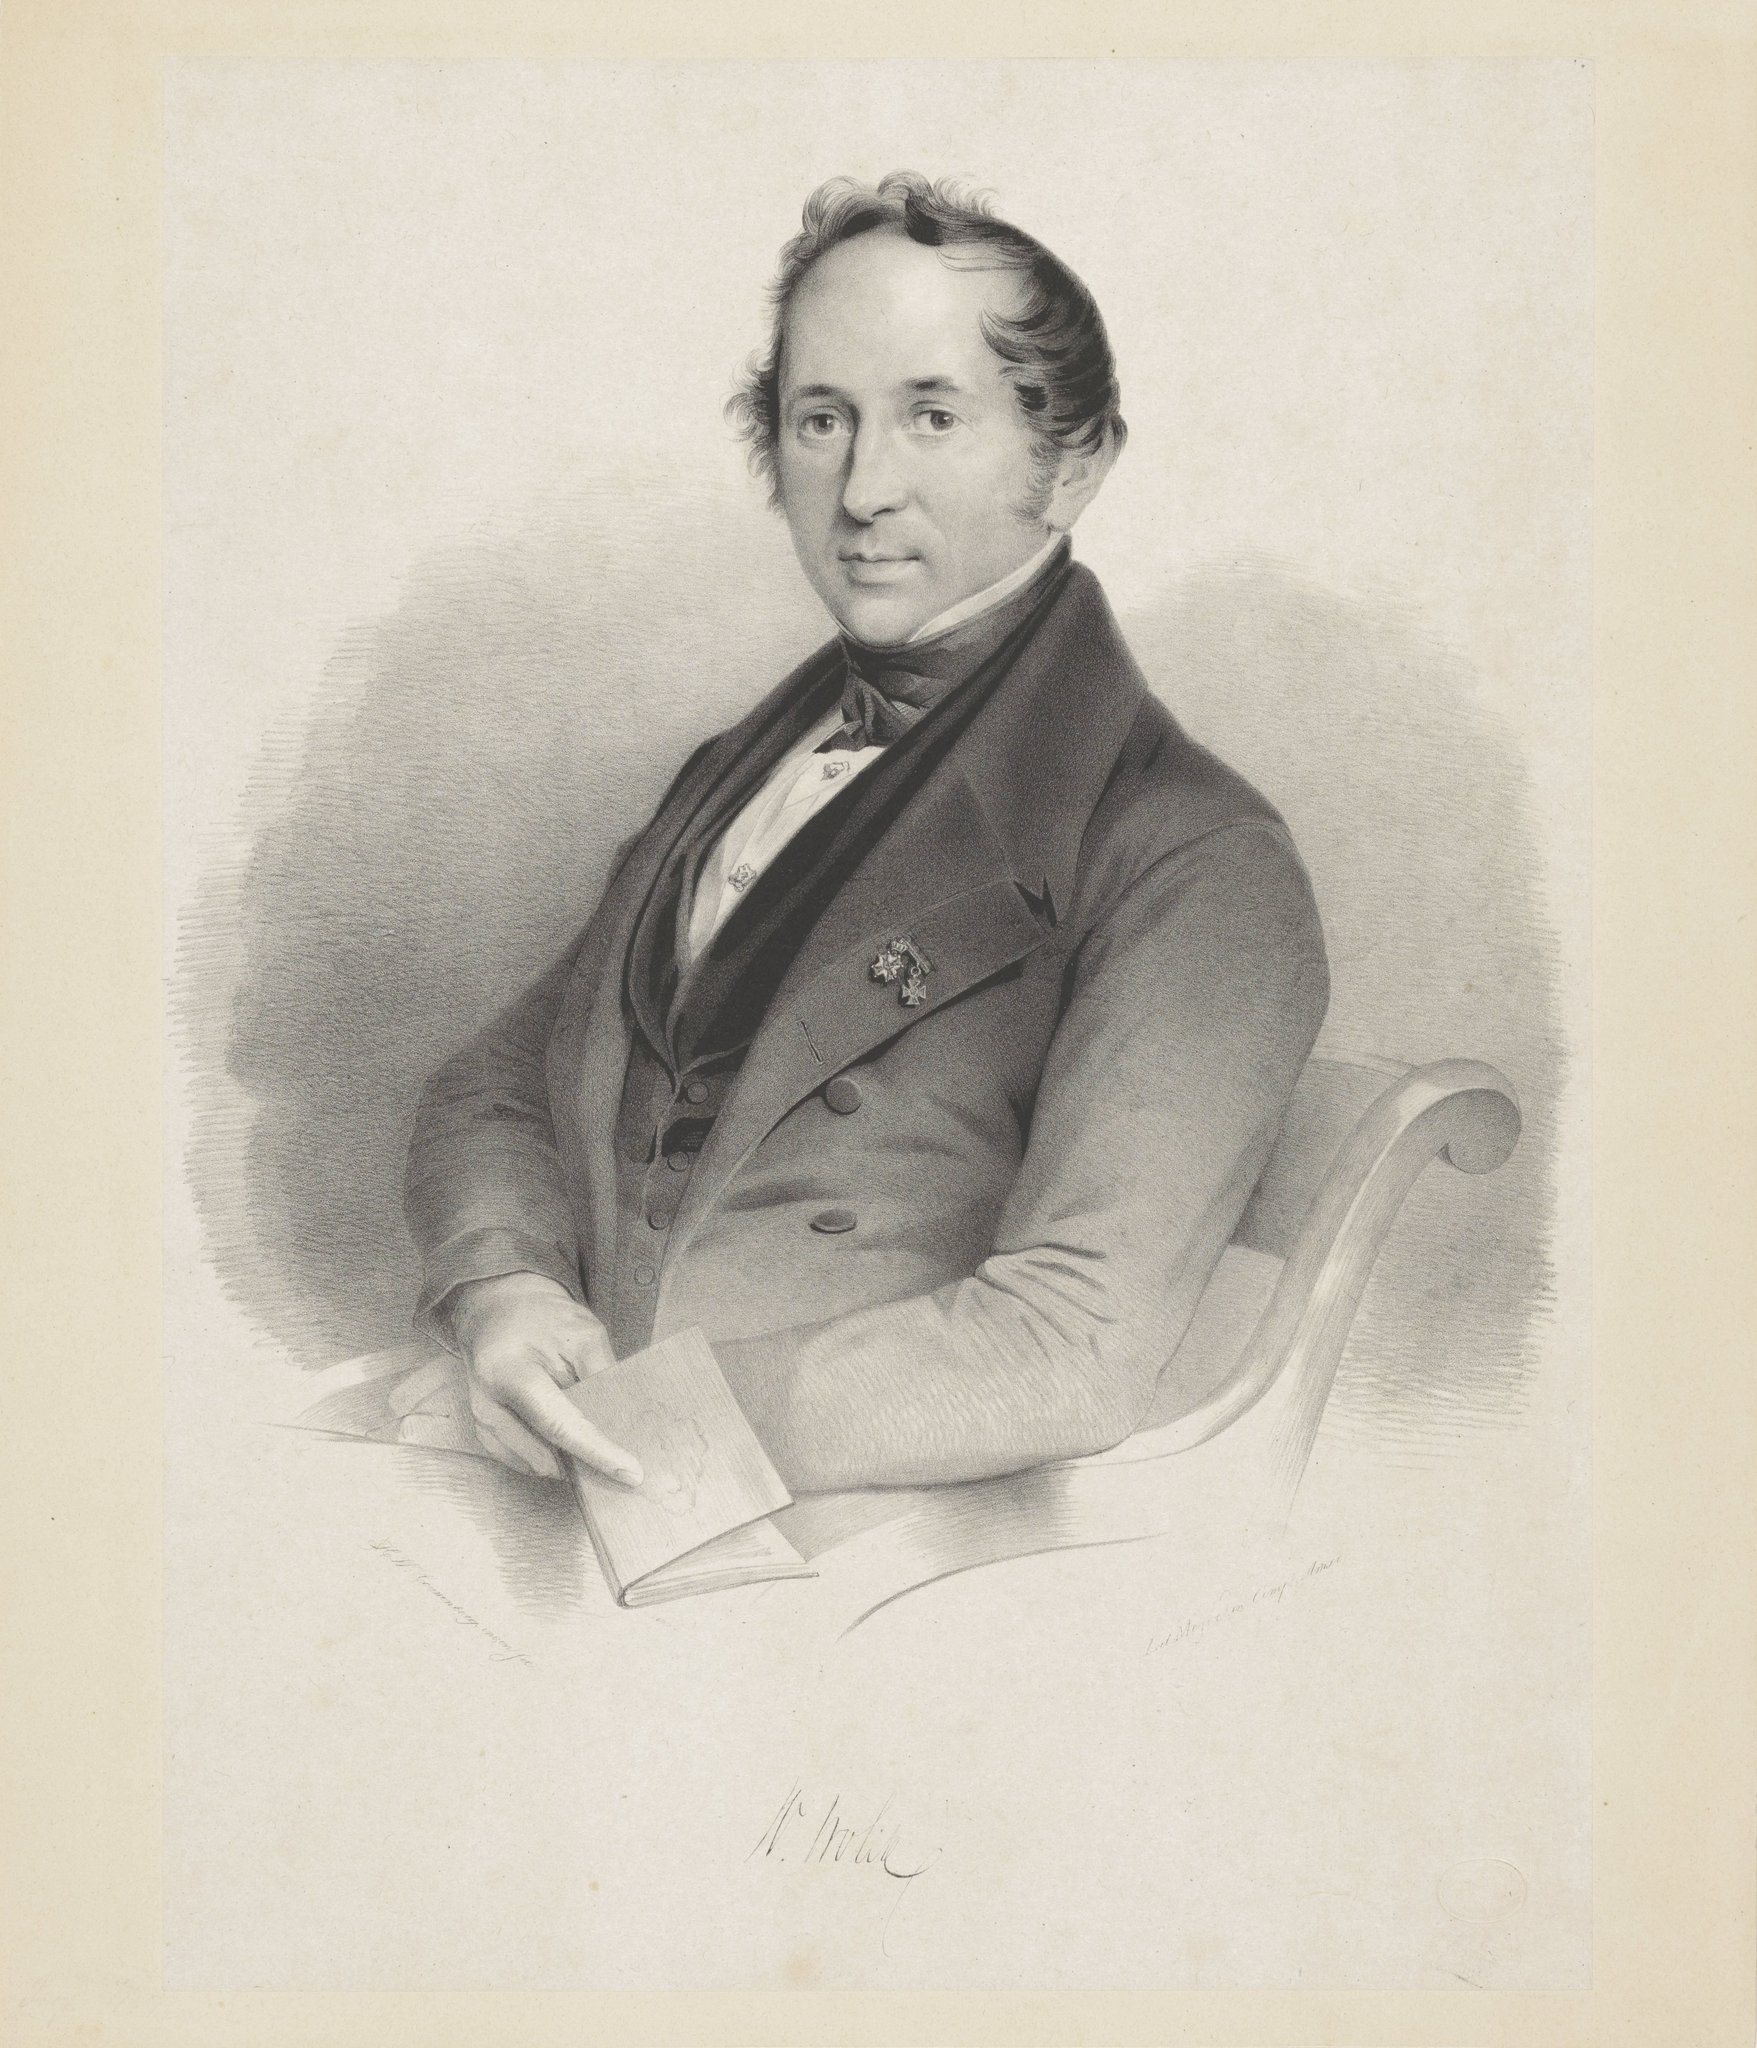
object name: print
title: Portret van Willem Vrolik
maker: henricus wilhelmus couwenberg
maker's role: draughtsman, print maker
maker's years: 1814-1845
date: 1824-1845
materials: paper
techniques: lithograph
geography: amsterdam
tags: historical persons (+ half-length portrait)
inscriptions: collector's mark: Lugt 2228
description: De geportretteerde zit op een stoel. Op de revers van zijn jas draagt hij twee ridderorden en in zijn rechterhand heeft hij een boek. Onder het portret staat zijn signatuur.